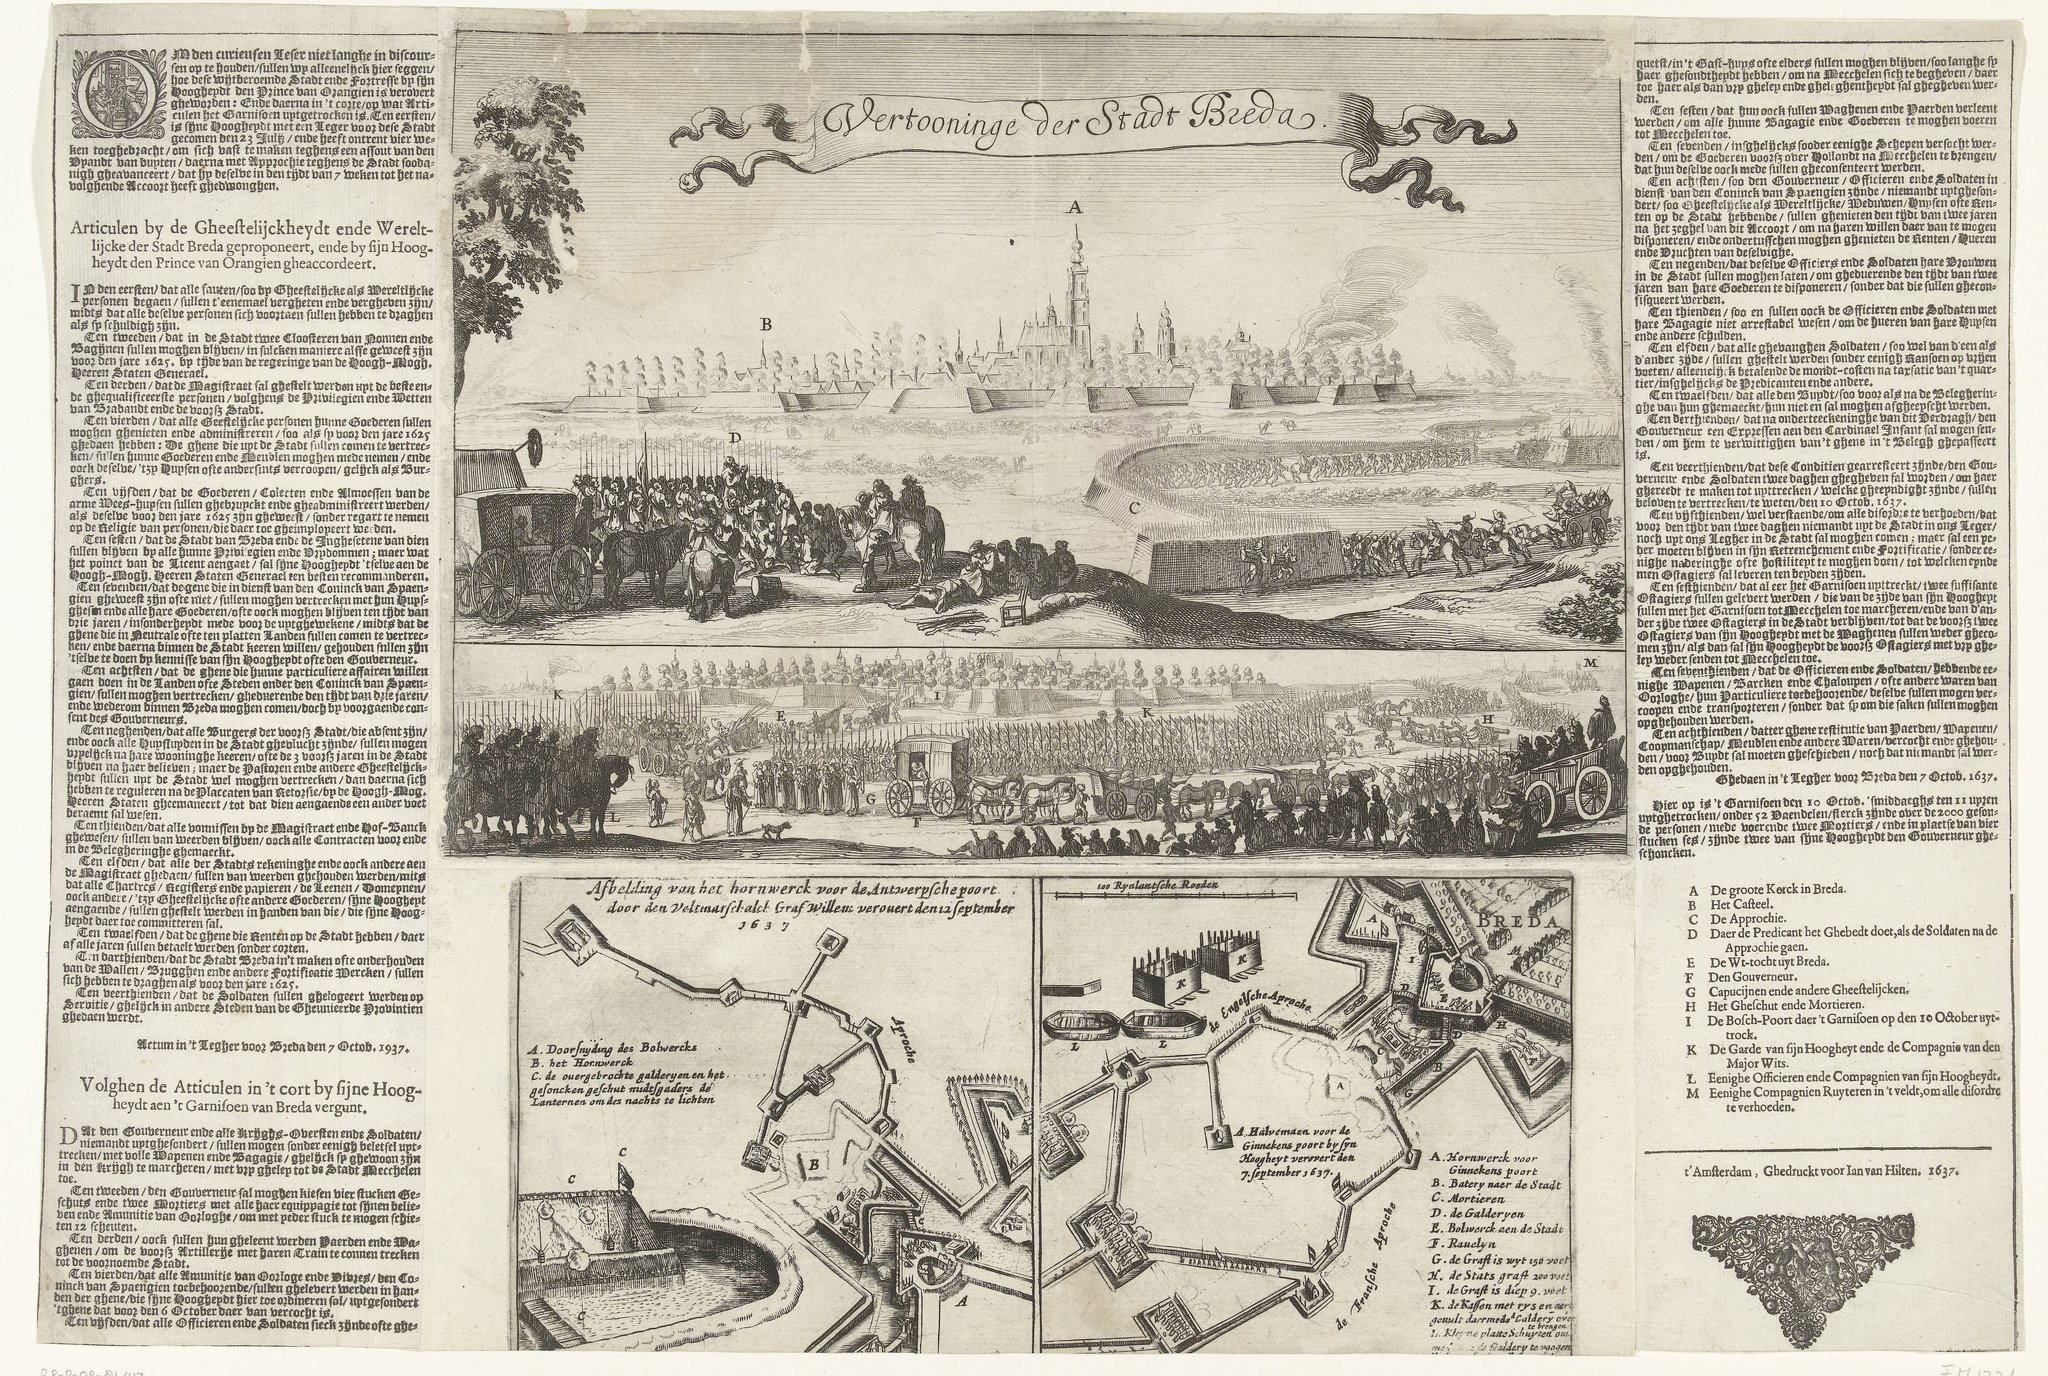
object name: print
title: Verovering van Breda en de uittocht van het Spaanse garnizoen, 1637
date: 1637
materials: paper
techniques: engraving, etching, letterpress printing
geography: northern netherlands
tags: delft, the hague, frederick henry (prince of orange), prayer or religious service before battle, maps of separate countries or regions, siege, position war, capture of city (after the siege), retreat of the defeated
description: De belegering en verovering van Breda door het Staatse leger onder Frederik Hendrik, 23 juli - 10 oktober 1637. Blad met meerdere voorstellingen en tekstbladen. Centraal boven een plaat met een gezicht op de belegerde stad met een gebed door een preikant voor de soldaten die naar de loopgraven gaan, daaronder de uittocht van de Spaanse troepen uit de stad op 10 oktober. Onderaan een plaat met twee details van de veroveringen van de Antwerpse Poort en de Ginnekens Poort op respectievelijk 12 en 7 september. Links en rechts tekstbladen met de artikelen van overgave en de legenda A-M.